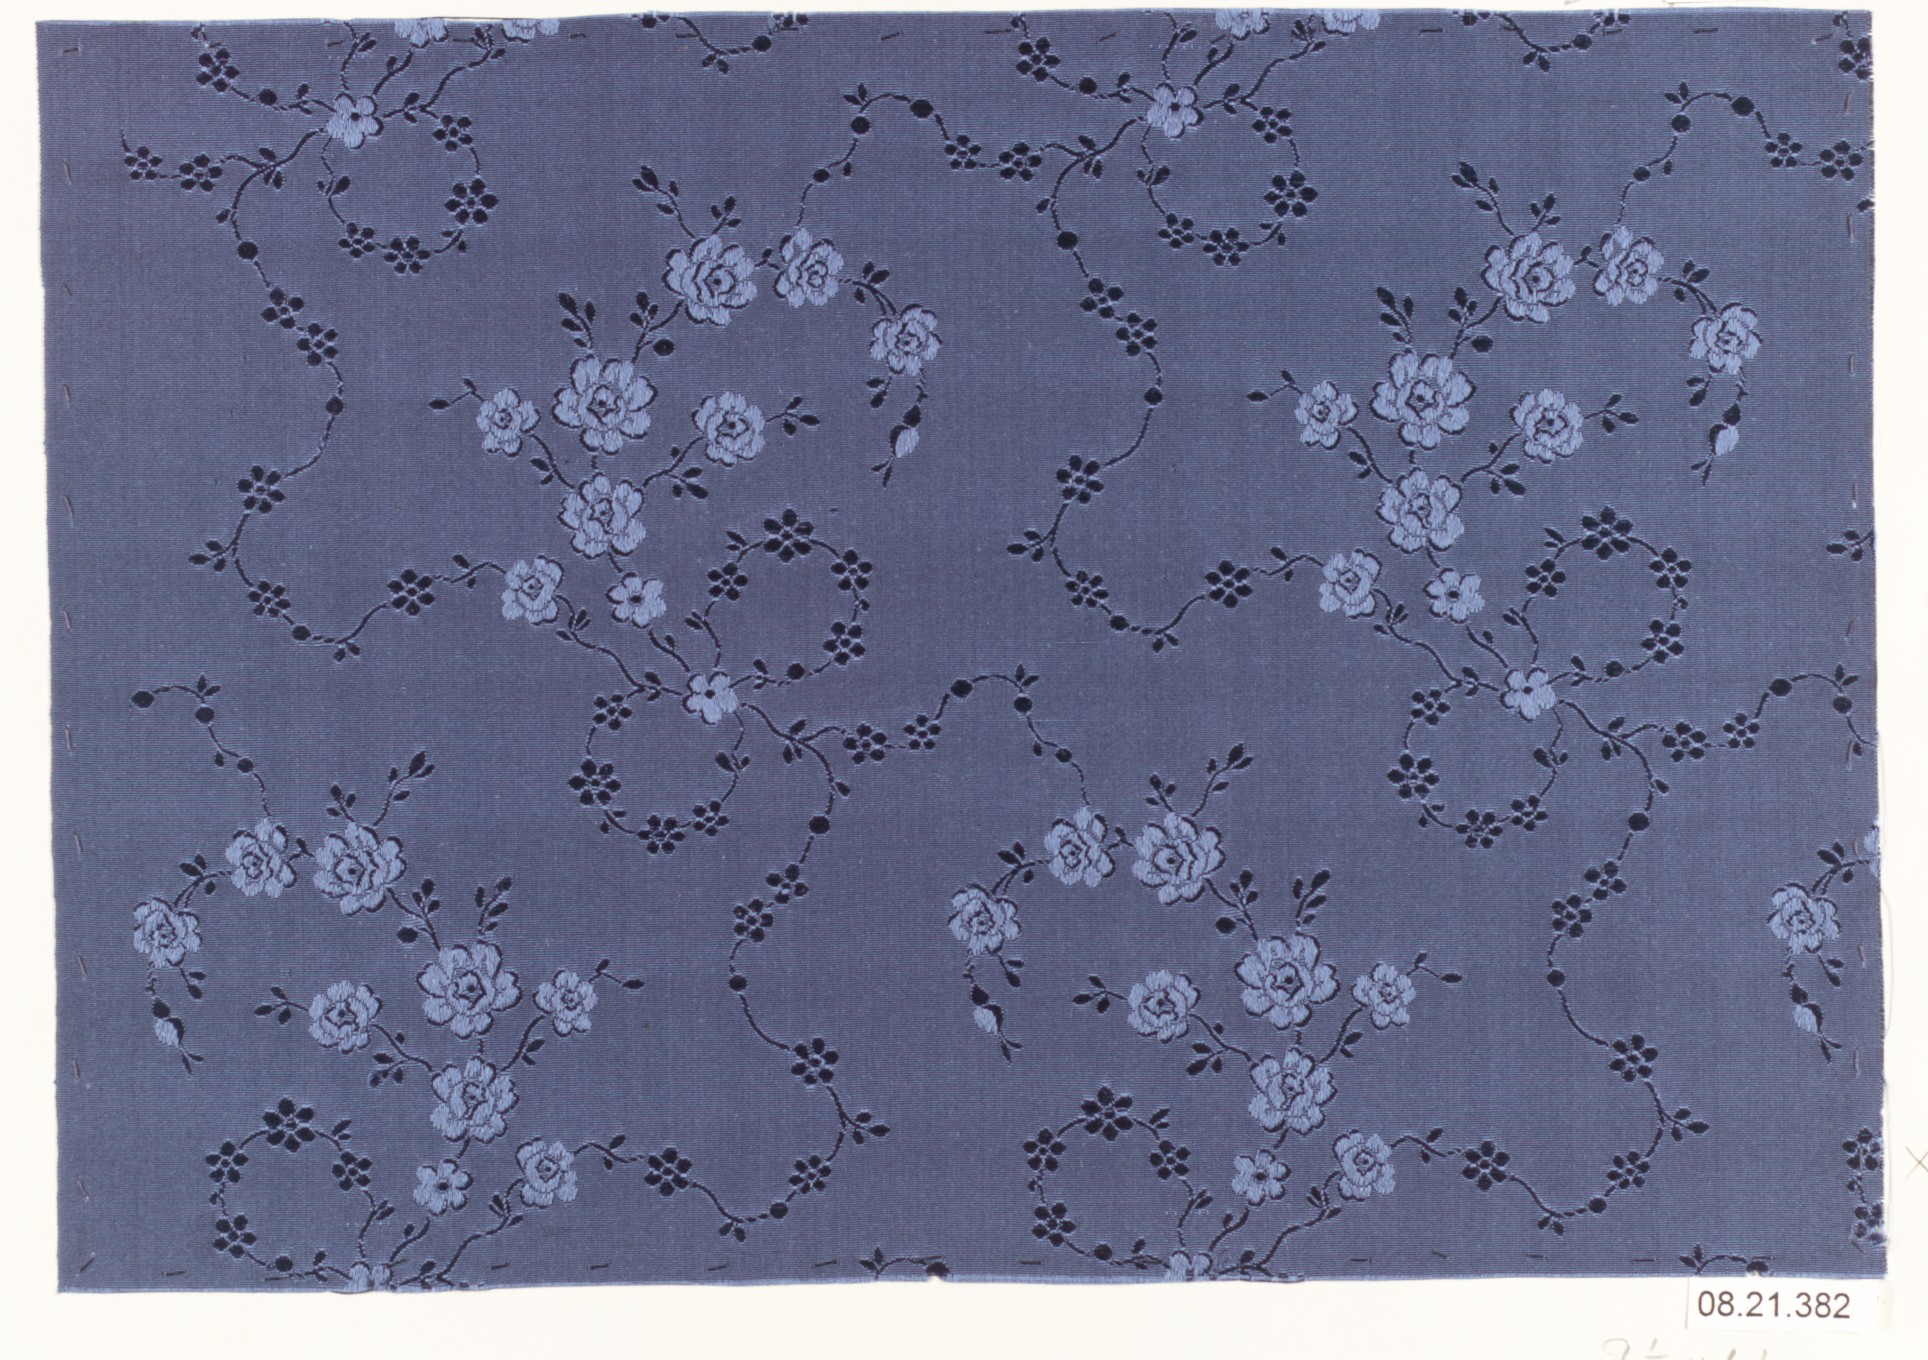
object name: textile sample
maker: Anonymous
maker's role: designer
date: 1900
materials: silk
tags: flowers